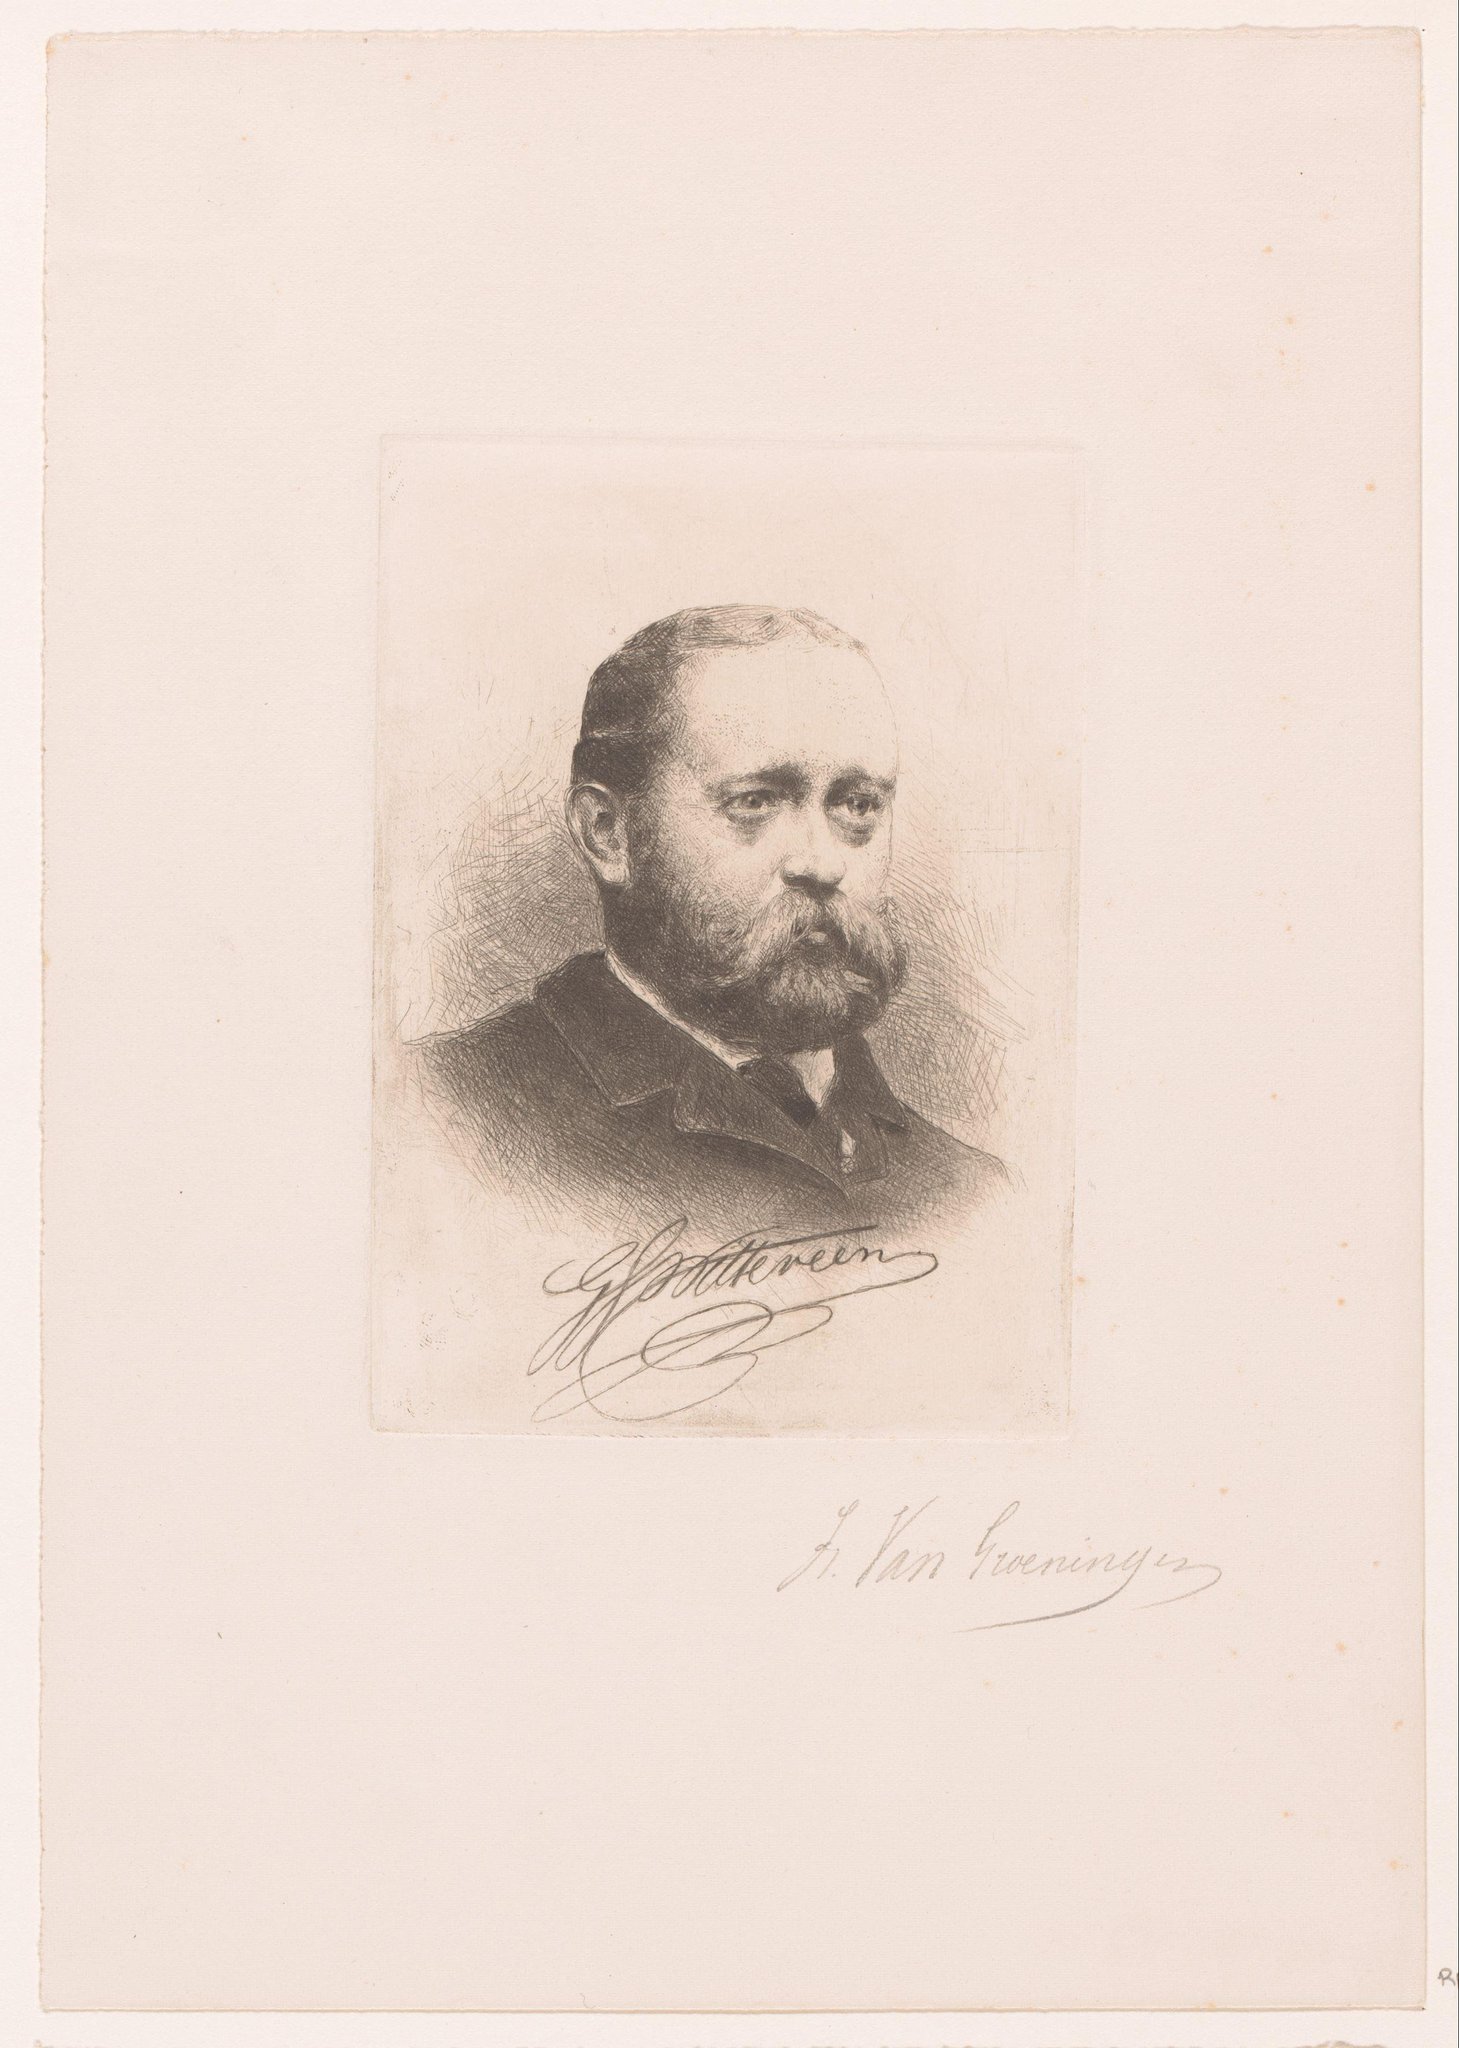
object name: print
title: Portret van een onbekende man, mogelijk G.J. Witteveen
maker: fr. van groeningen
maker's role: print maker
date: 1850-1910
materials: paper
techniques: etching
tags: anonymous historical person portrayed alone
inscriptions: collector's mark: Lugt 2228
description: Aangezien geboorte- en sterfdatum van de kunstenaar onbekend zijn, is voor de rechtenbepaling van dit object de verwervingsdatum gehanteerd.